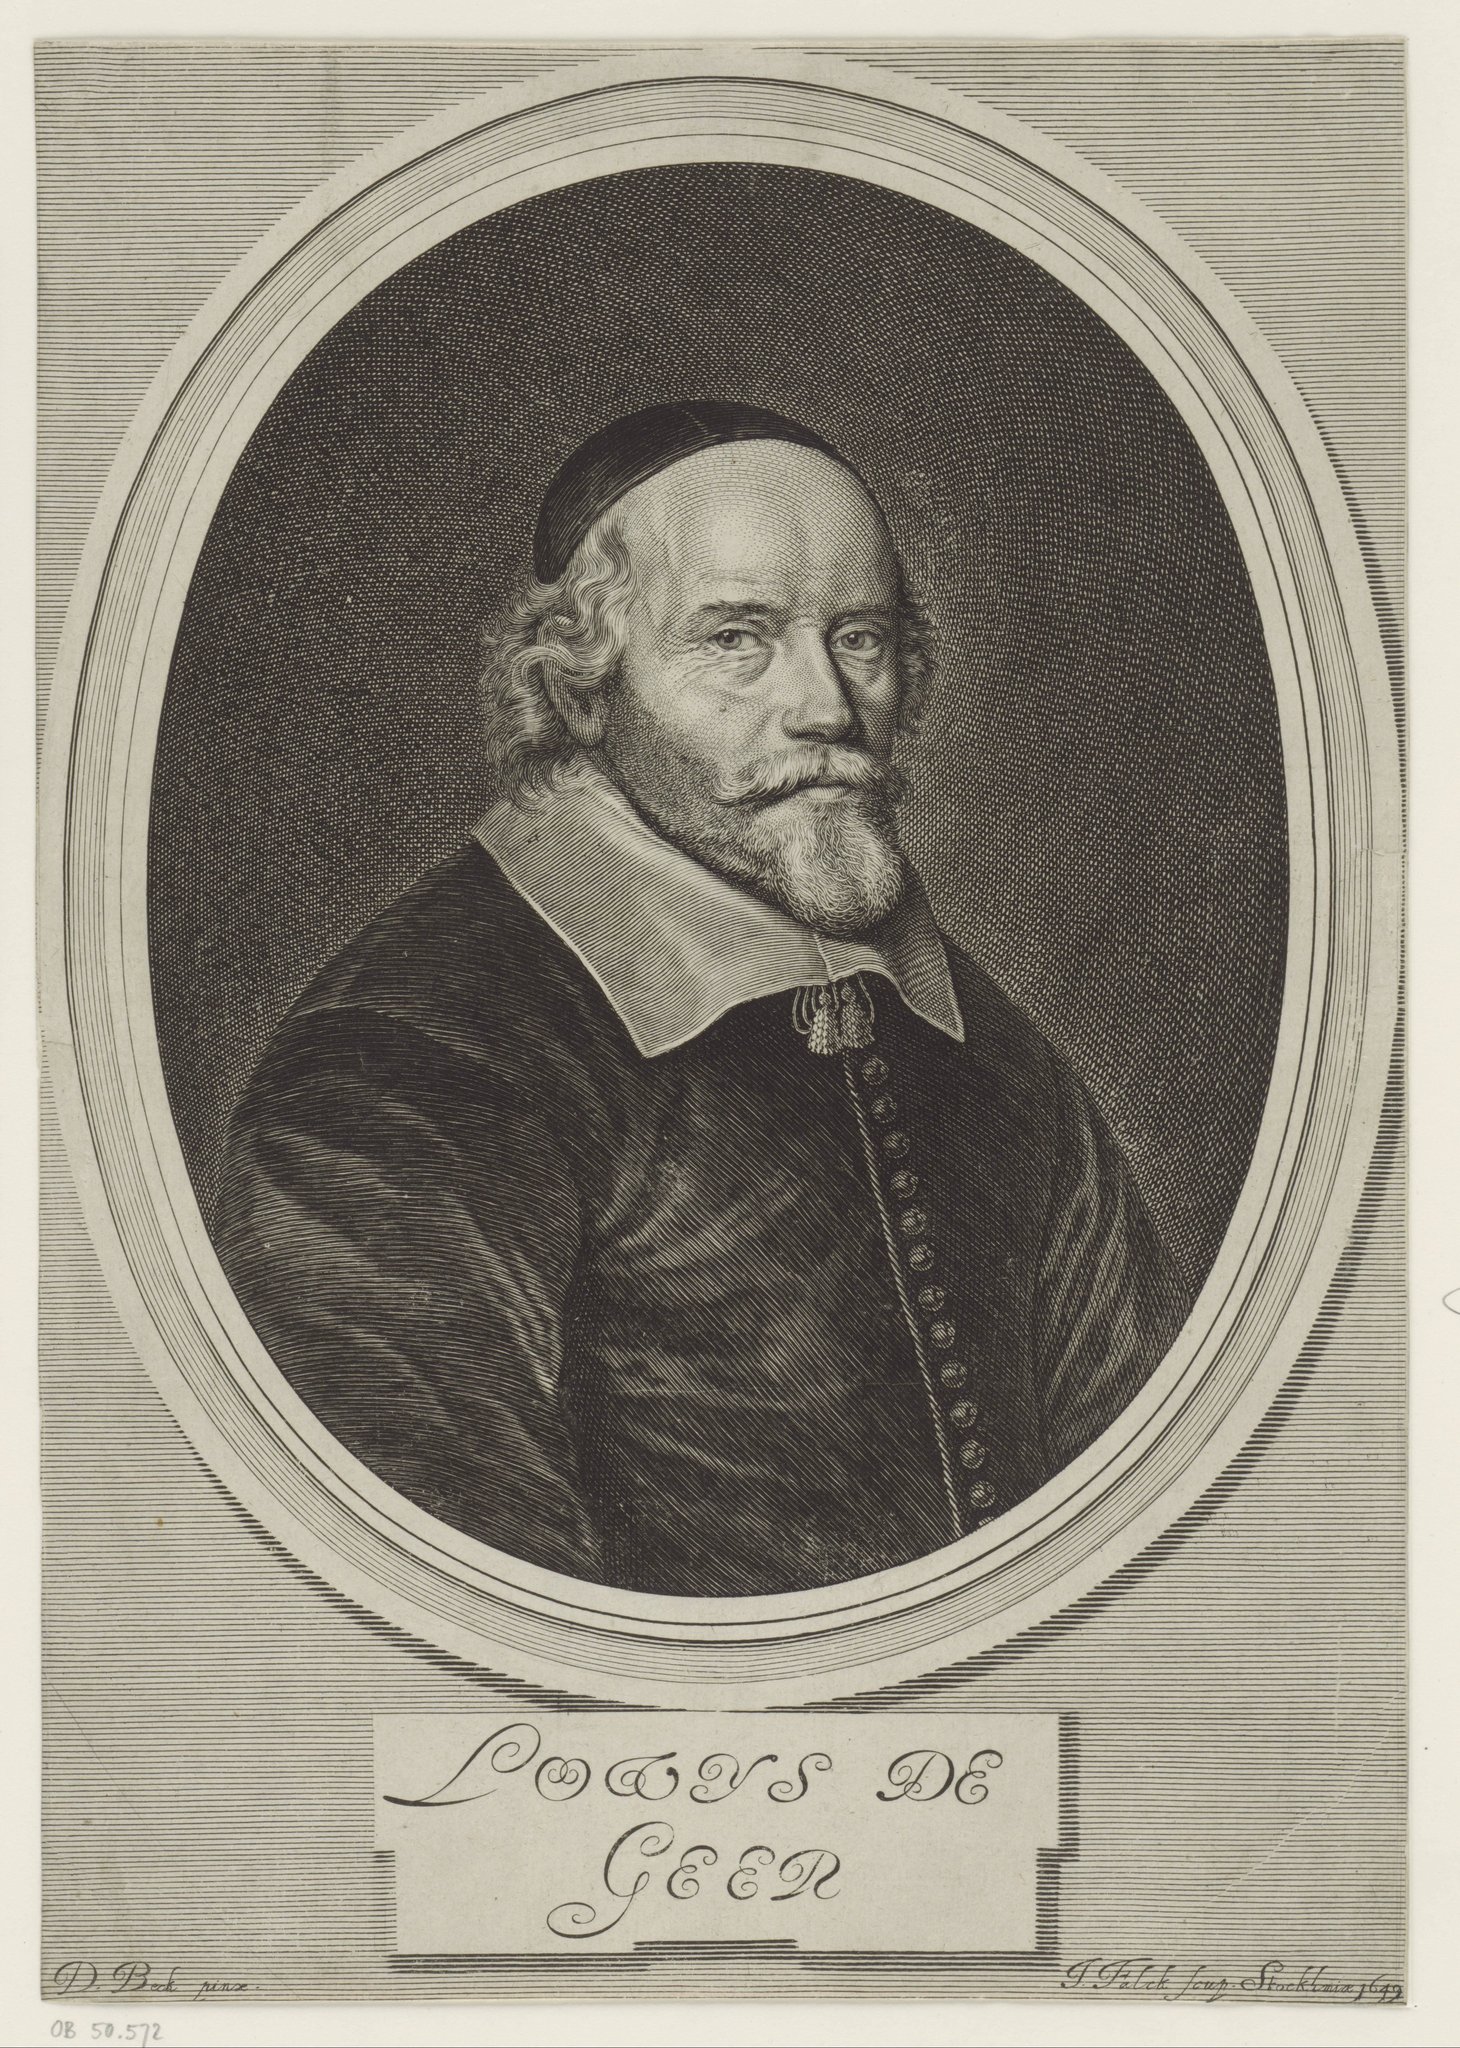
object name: print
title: Portret van Lodewijk de Geer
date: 1649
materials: paper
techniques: engraving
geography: stockholm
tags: liège, amsterdam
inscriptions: collector's mark: Lugt 963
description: Busteportret van de Nederlandse koopman Lodewijk (Louis) de Geer. Afgebeeld in toga met platte kraag en kalotje op het hoofd, in ovale omlijsting.